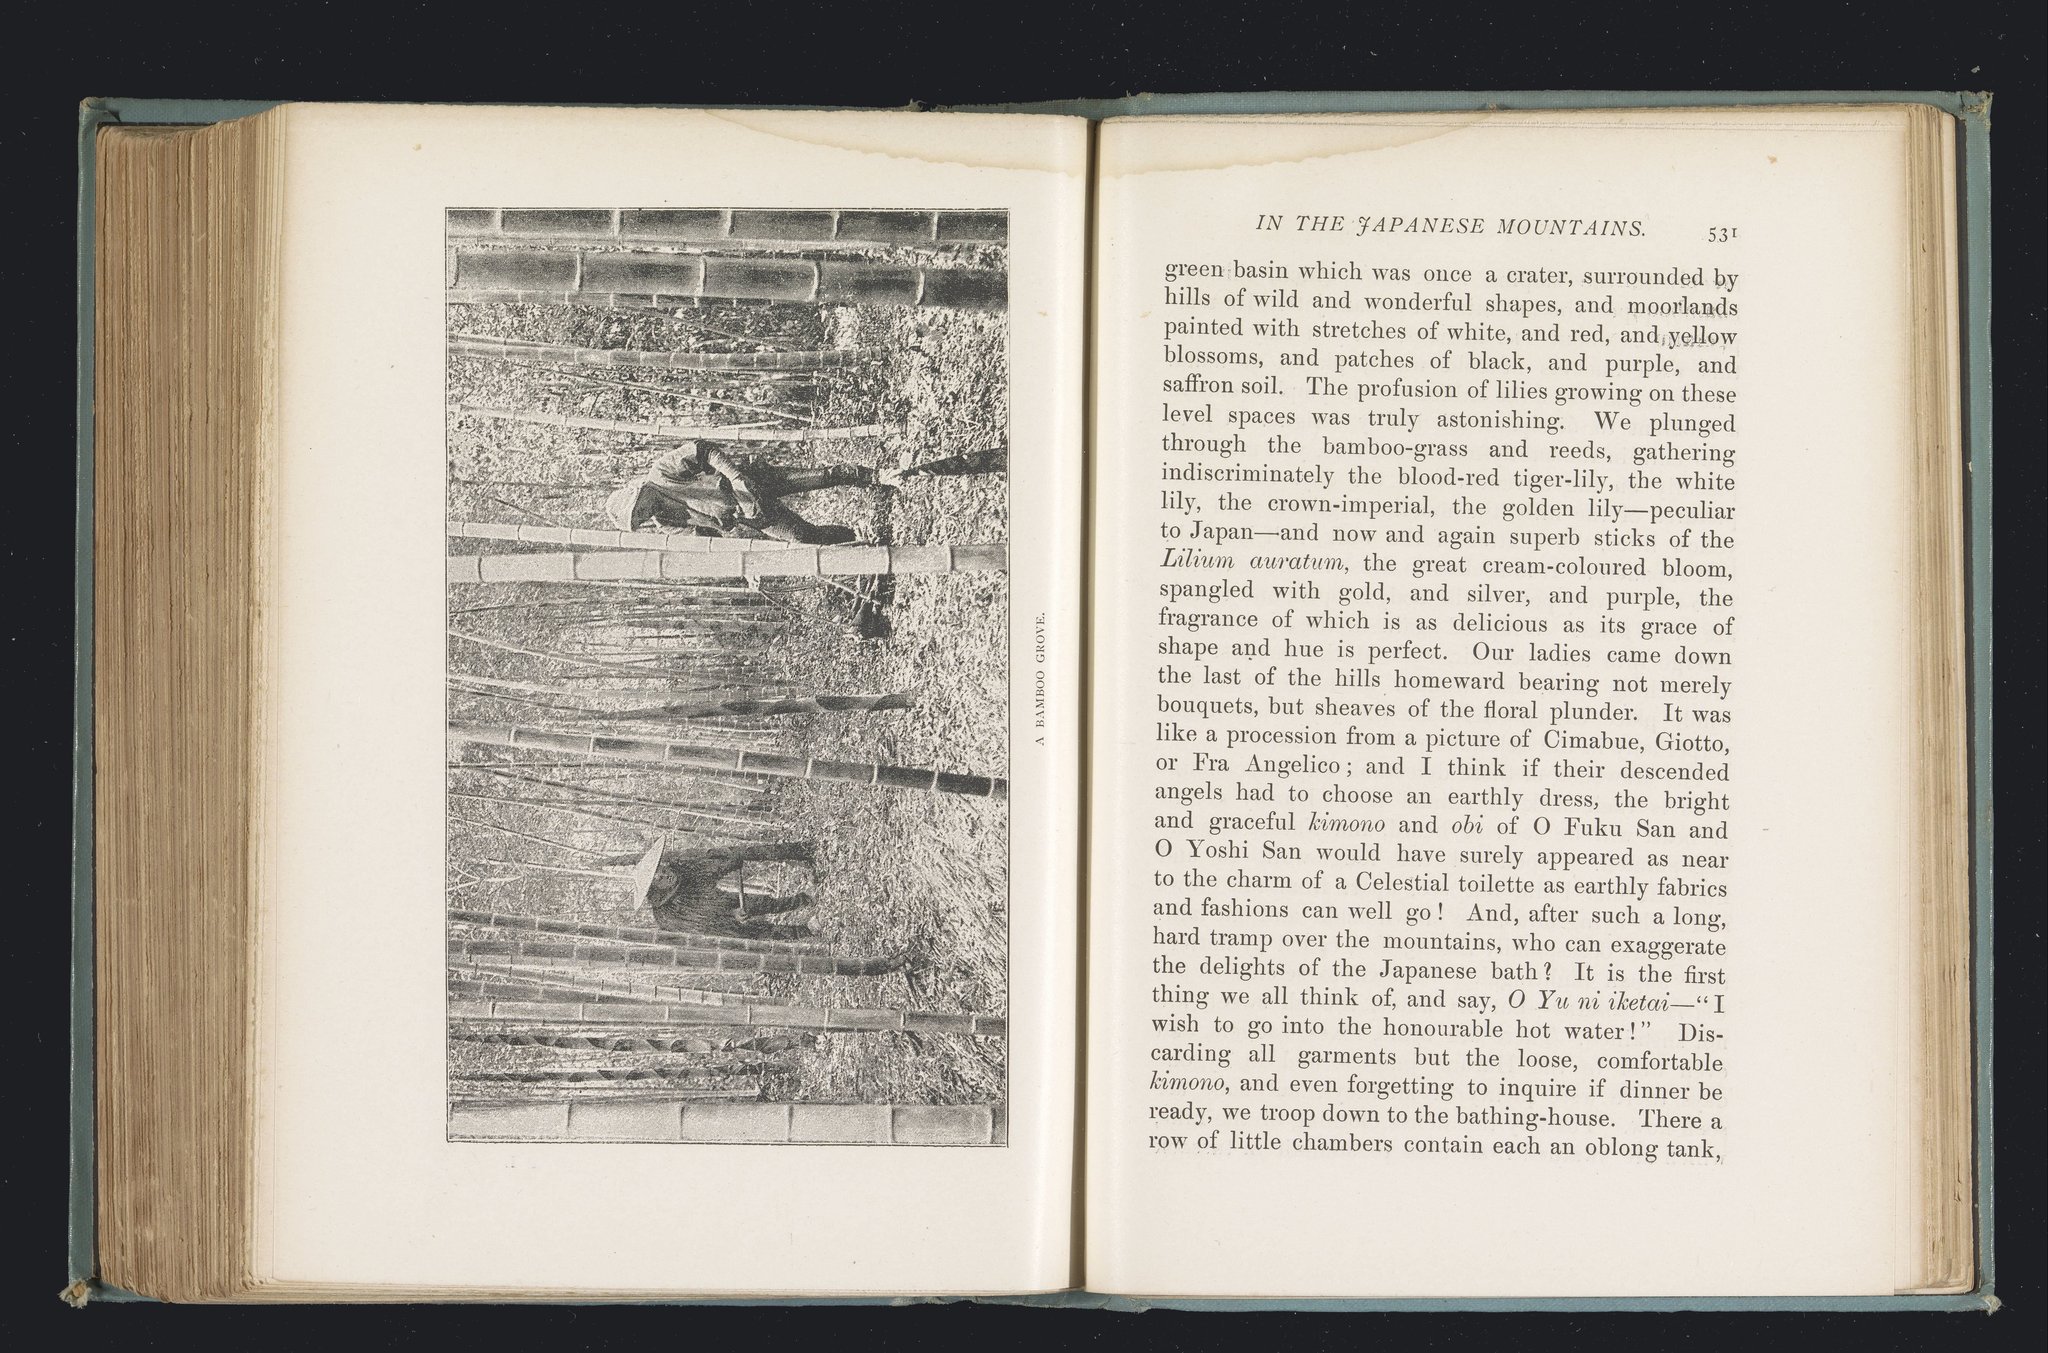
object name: page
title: A bamboo grove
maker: Anonymous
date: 1882-1892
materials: paper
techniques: autotype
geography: japan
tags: forest, wood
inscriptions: number: ‘2 L’